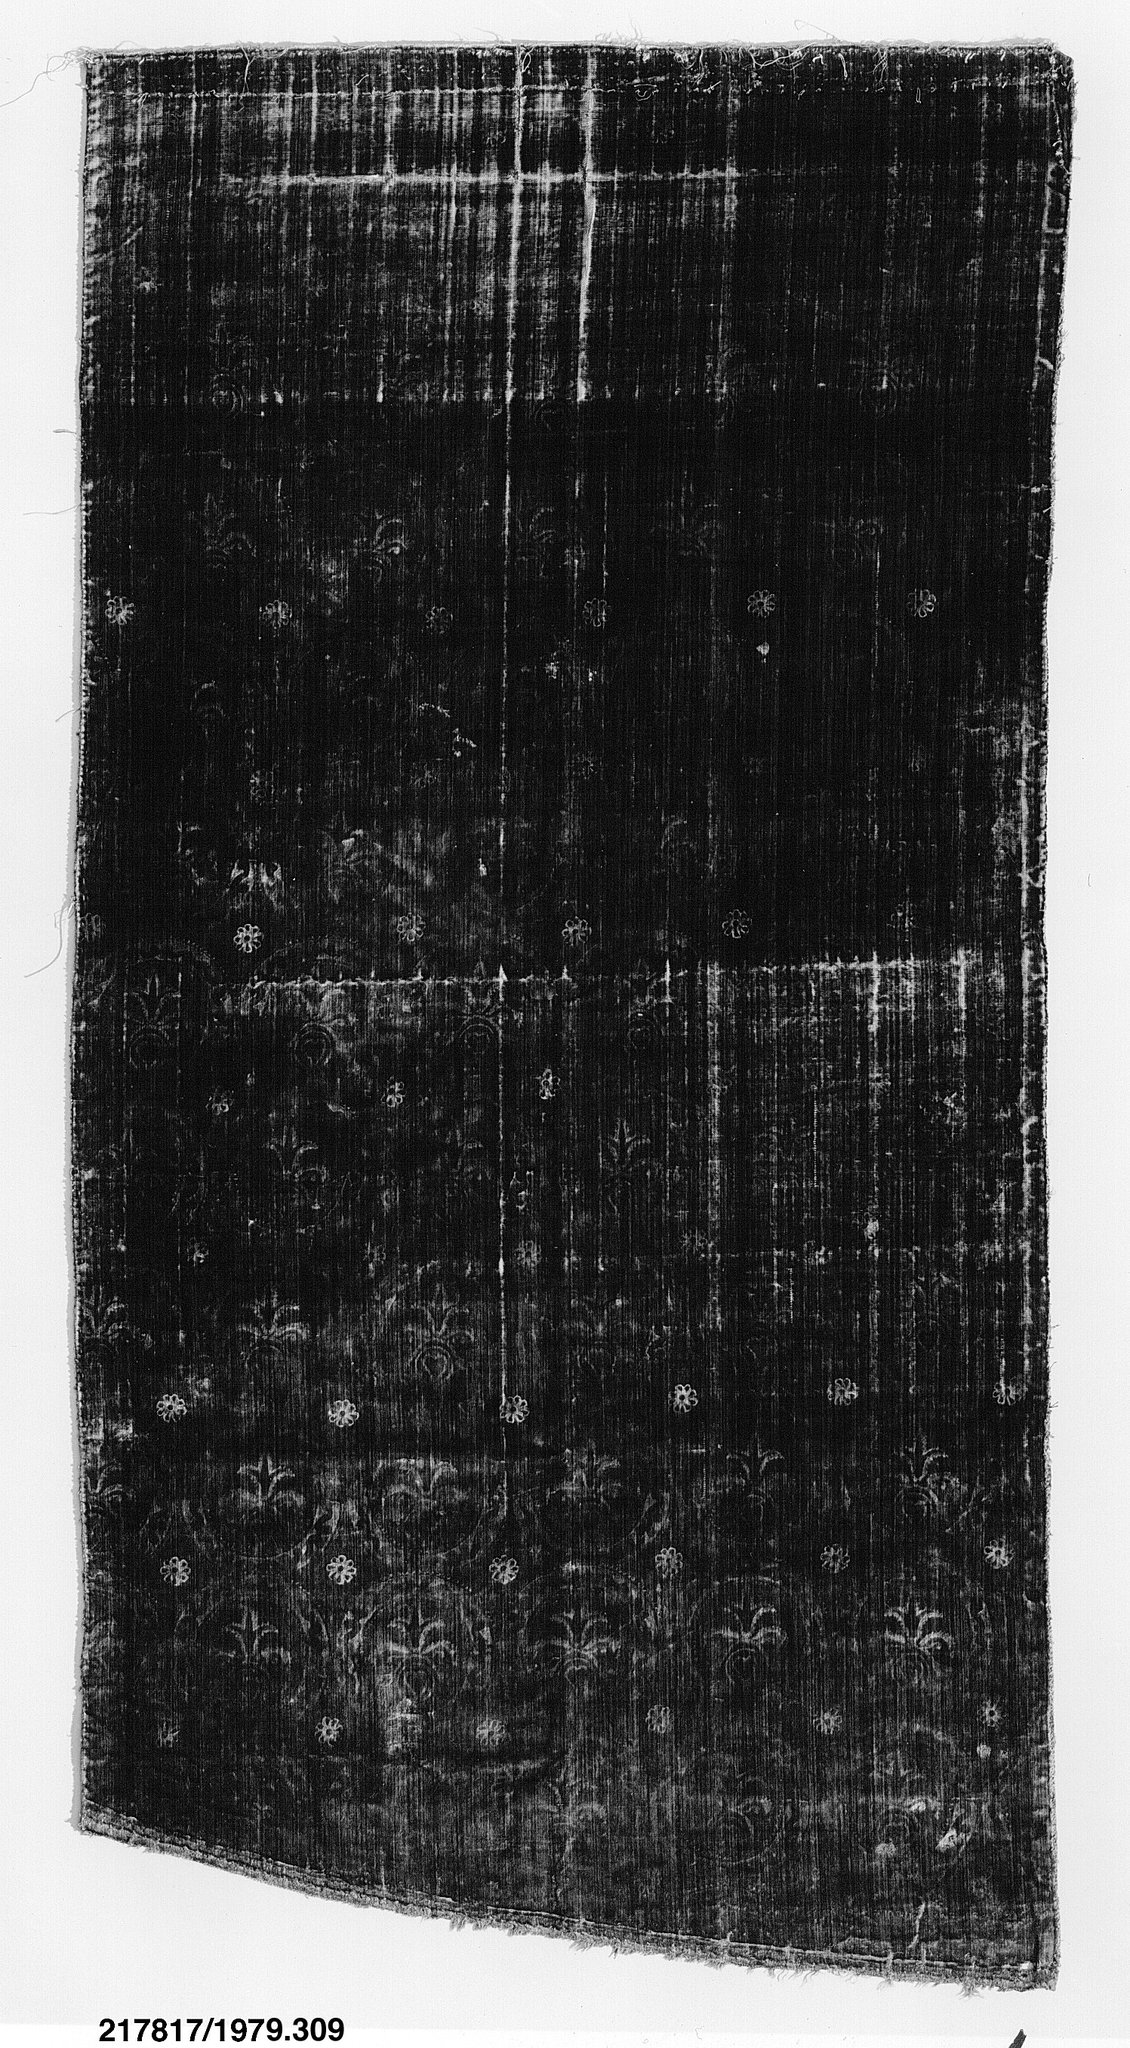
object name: length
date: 1501-1600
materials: silk